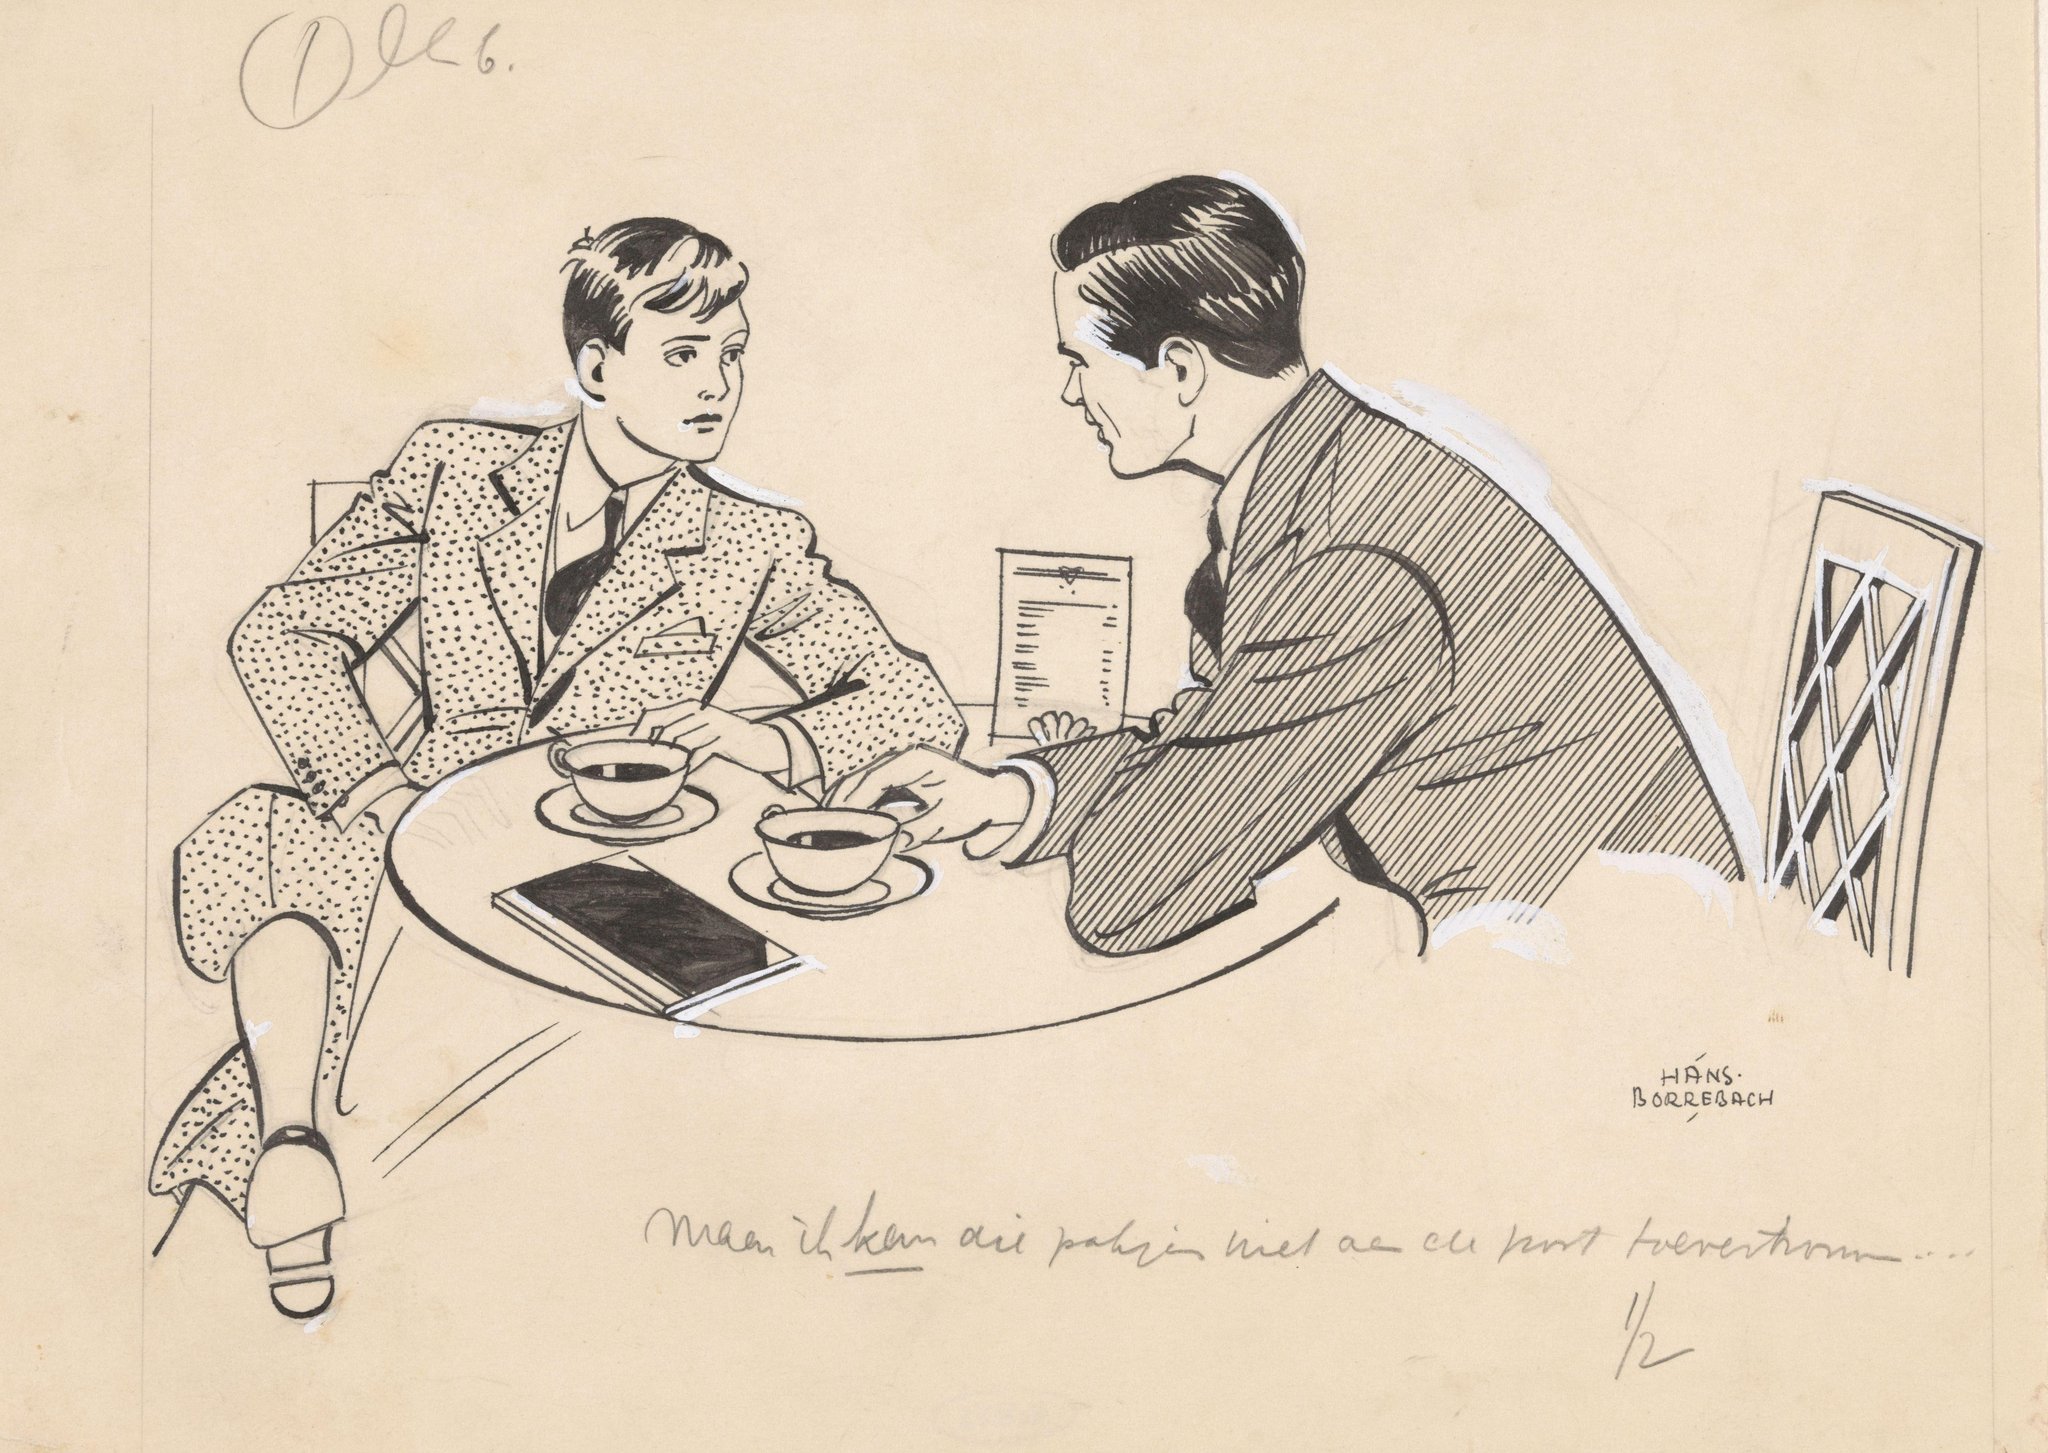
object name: drawing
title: Twee mannen in gesprek bij een kop koffie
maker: hans borrebach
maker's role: draughtsman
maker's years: 1903-1991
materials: paint, ink, paper, pencil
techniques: pen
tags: inn, coffee-house, public house, etc., conversation, dialogue; conversation piece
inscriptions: collector's mark: Lugt 2228a, signature: ‘HANS./ BORREBACH’, annotation: ‘1 blz 6/ maar ik kan die pakjes niet aan de post toevertrouwen...’, :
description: De twee mannen zitten aan een tafel, vermoedelijk in een koffiehuis. Op tafel staan twee koffiekopjes en ligt een schrift.